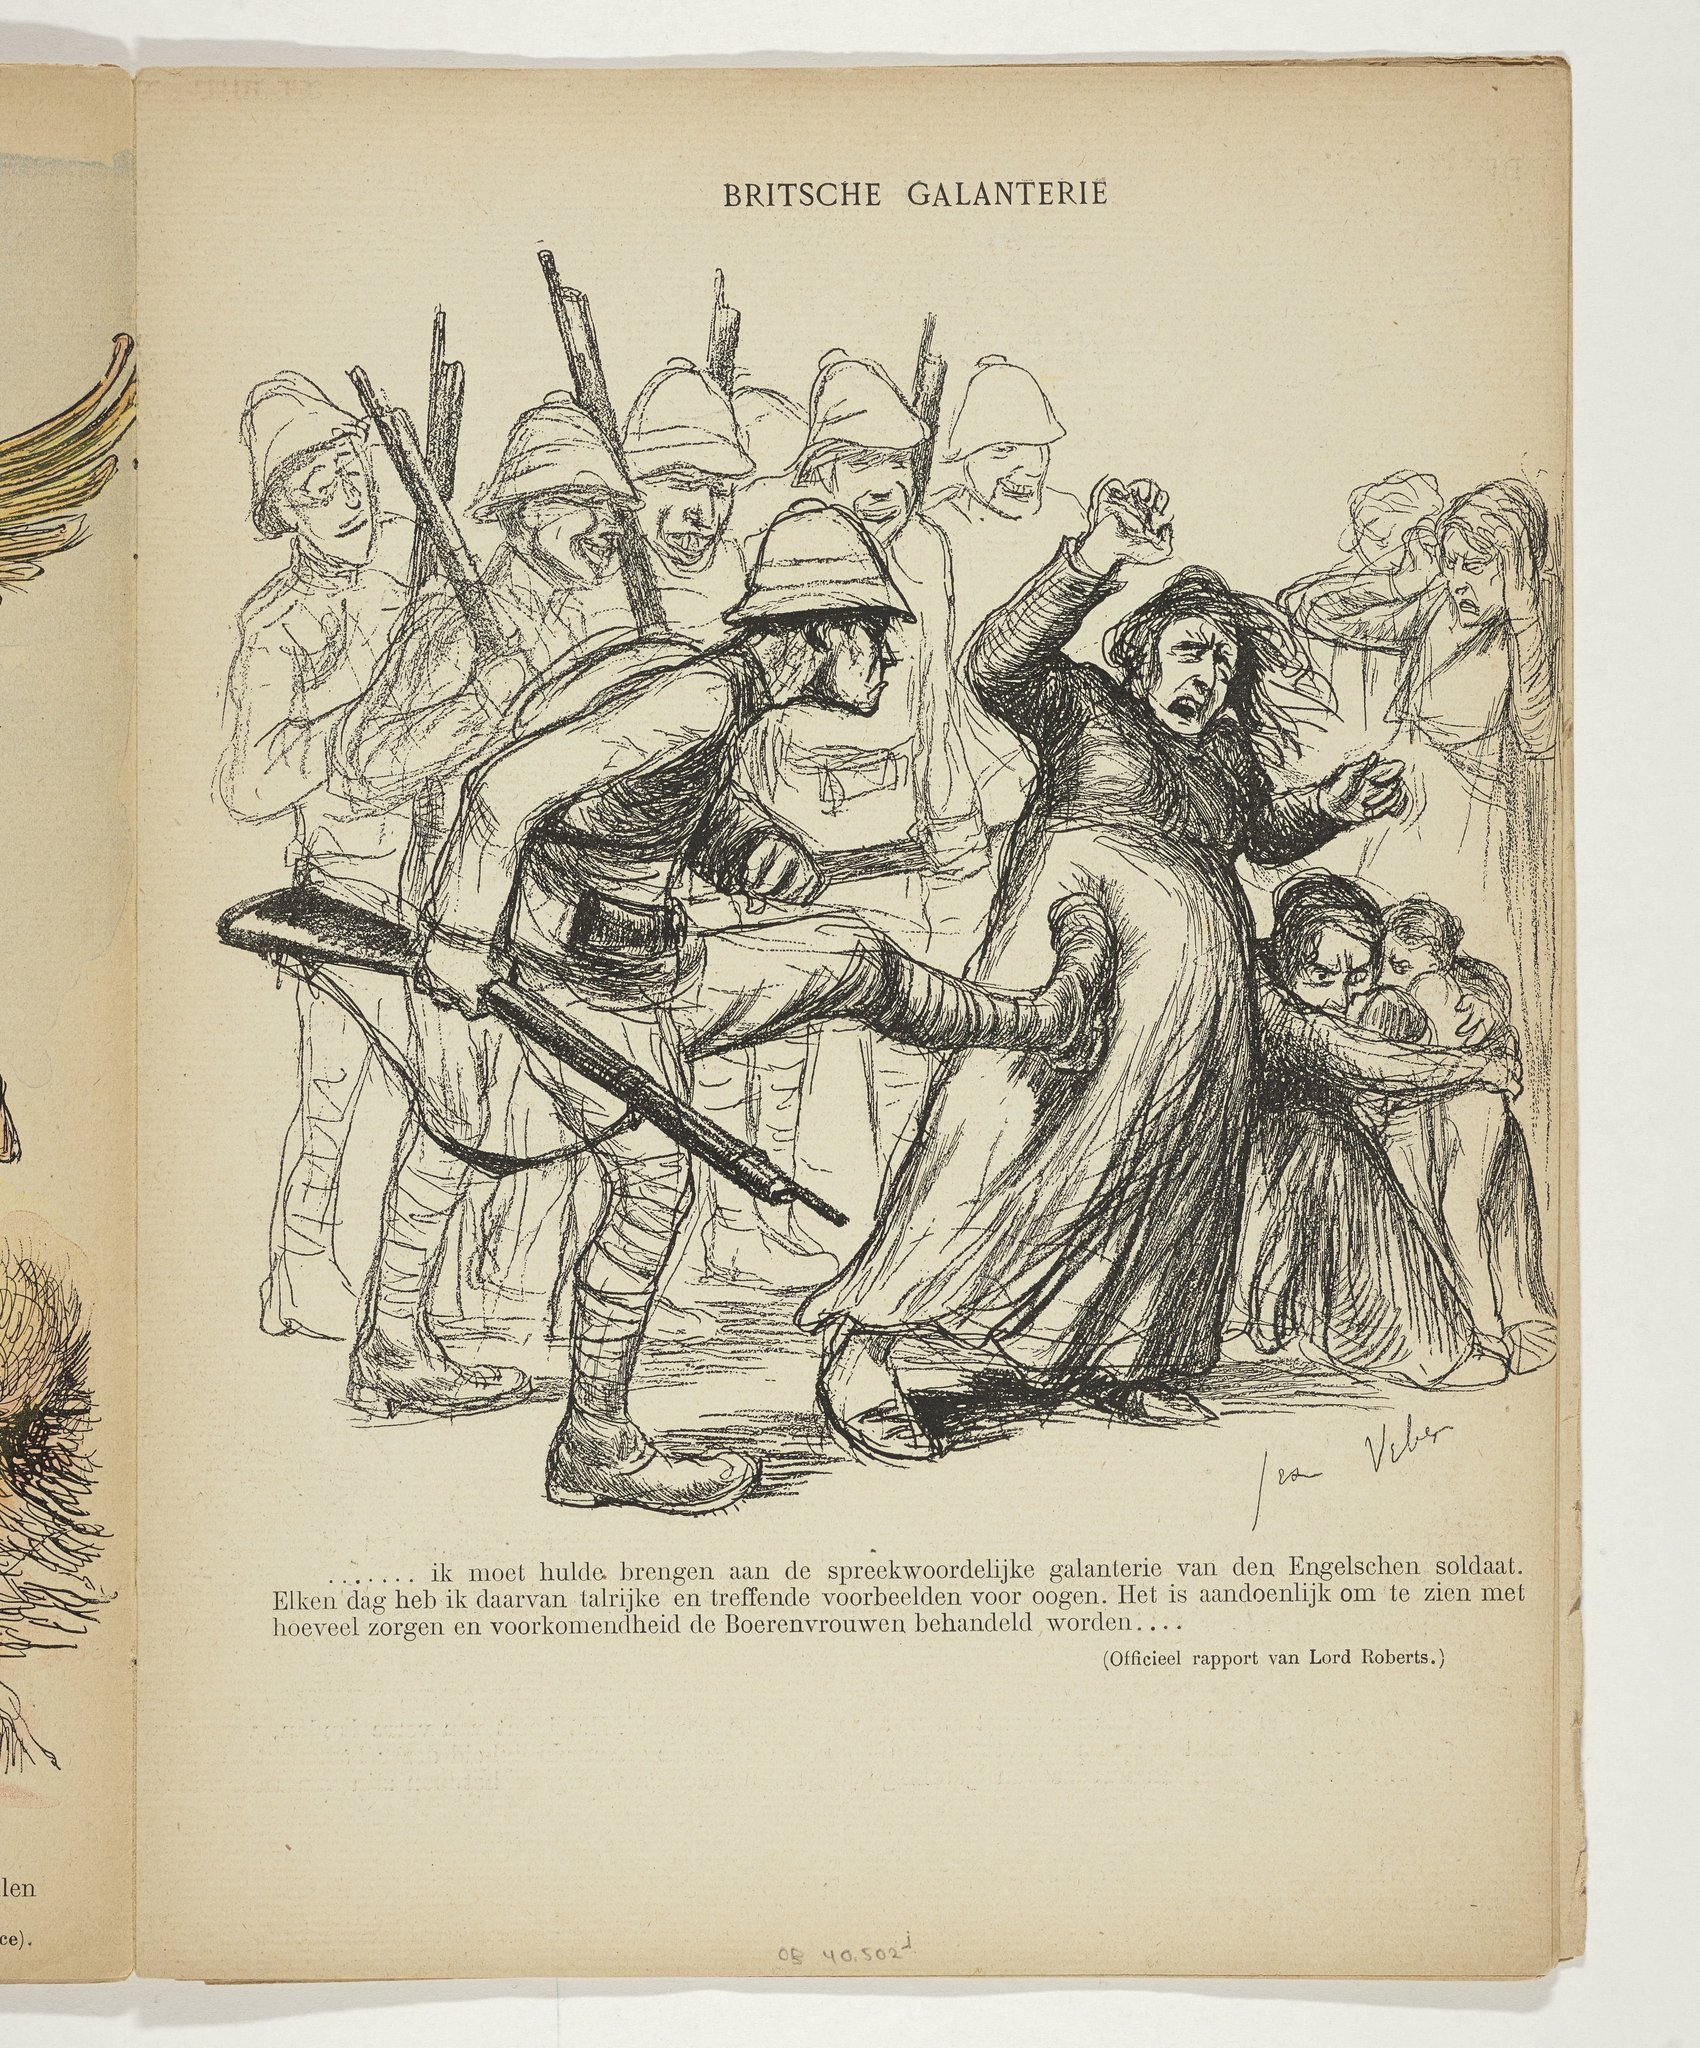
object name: page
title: Britse soldaat schopt Boerenvrouw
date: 1901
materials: paper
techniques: letterpress printing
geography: amsterdam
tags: horrors of war, the soldier; the soldier's life, political caricatures and satires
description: Prent maakt deel uit van een tijdschrift met spotprenten op de Tweede Boerenoorlog. Met vierregelig onderschrift: ....... ik moet hulde brengen aan de spreekwoordelijke galanterie van den Engelschen soldaat ... (Officieel rapport van Lord Roberts).